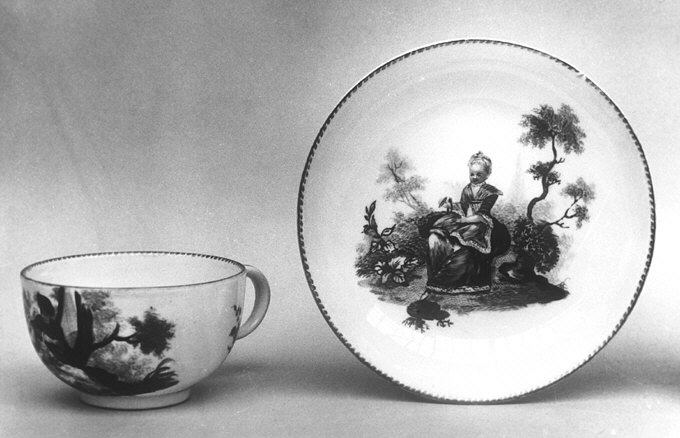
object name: cup and saucer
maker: meissen manufactory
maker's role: manufactory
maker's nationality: german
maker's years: 1710-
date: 1765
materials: hard paste porcelain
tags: women,trees